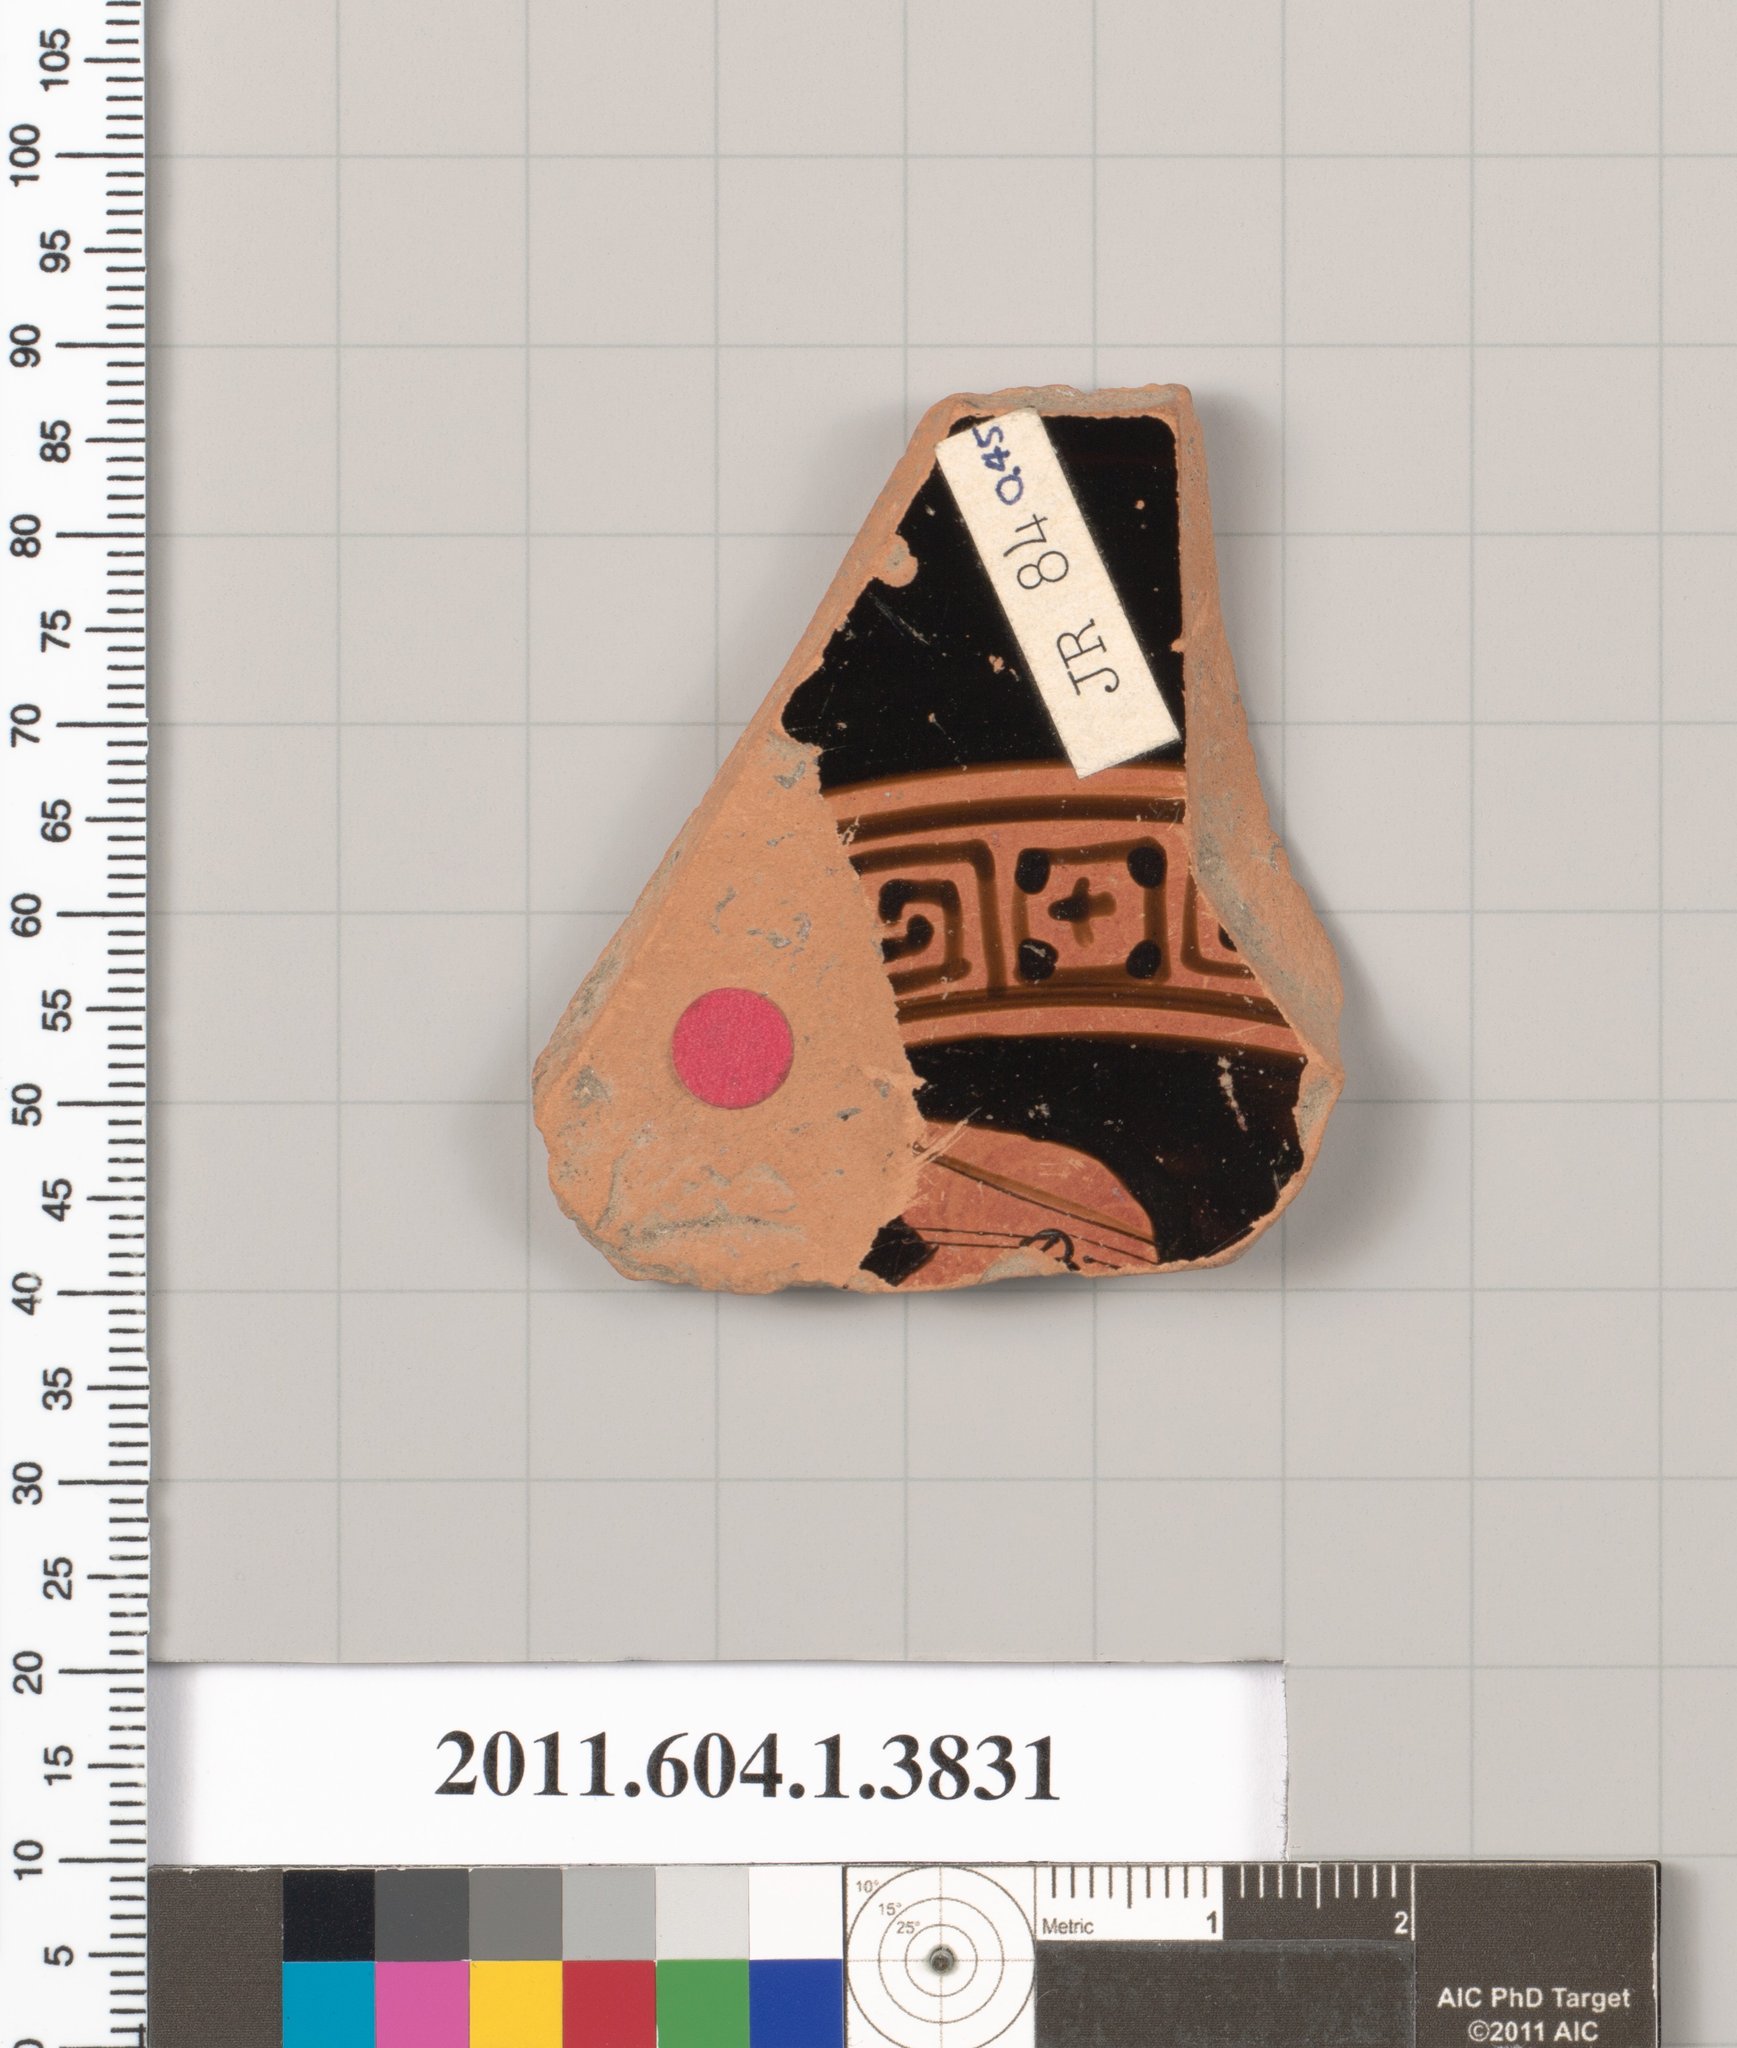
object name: kylix fragment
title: Terracotta fragment of a kylix (drinking cup)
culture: greek, attic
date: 475-451 BCE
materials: terracotta